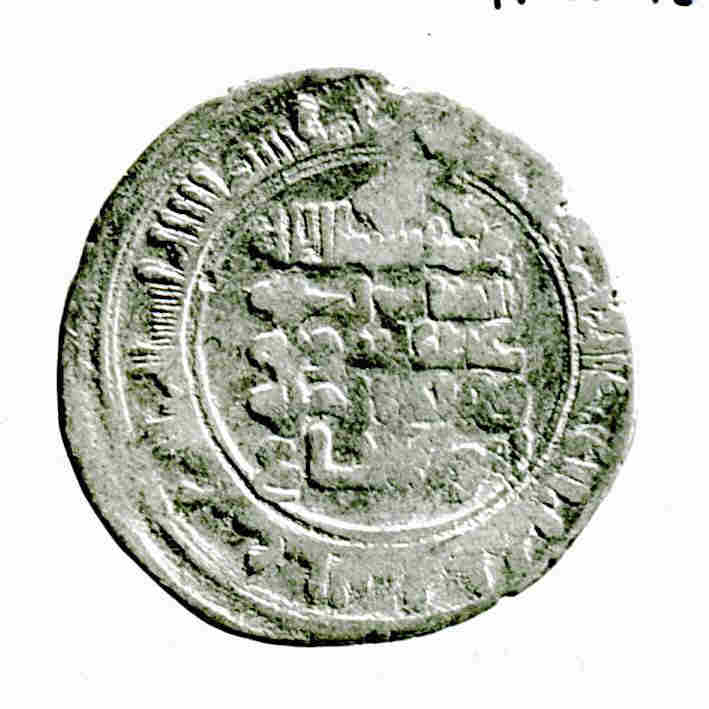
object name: coin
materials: silver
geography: iran